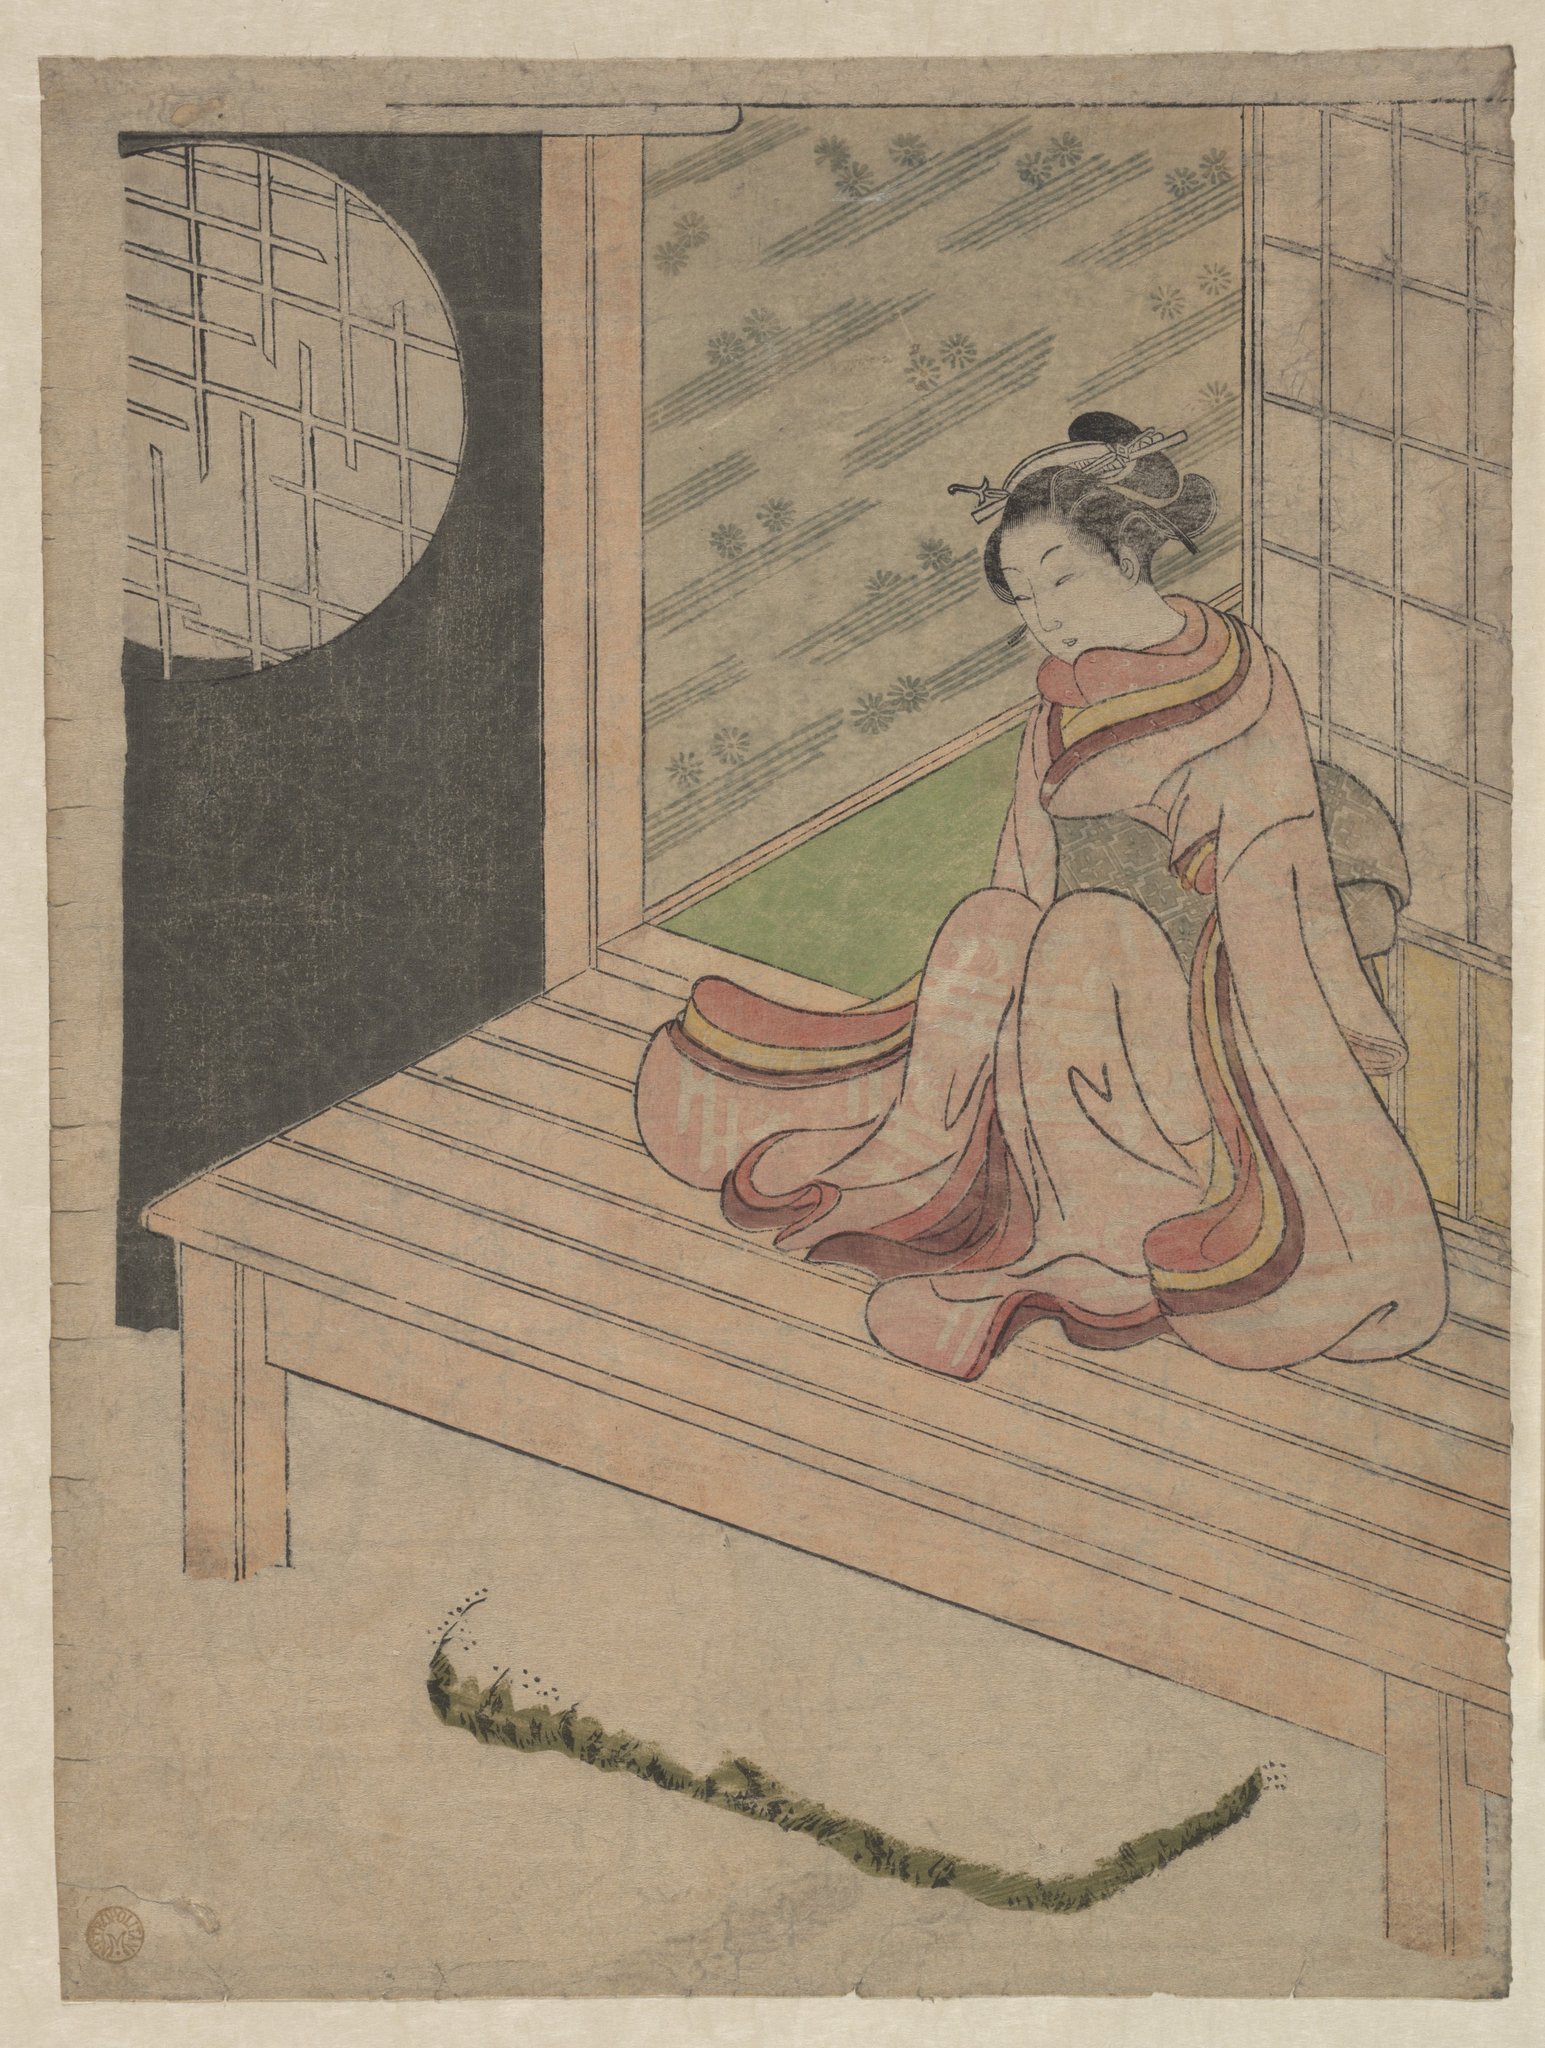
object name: print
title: A Young Woman Seated upon the Engawa of a House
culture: japanese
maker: suzuki harunobu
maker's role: artist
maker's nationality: japanese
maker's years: 1725-1770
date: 1765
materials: ink, paper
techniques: woodblock print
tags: women